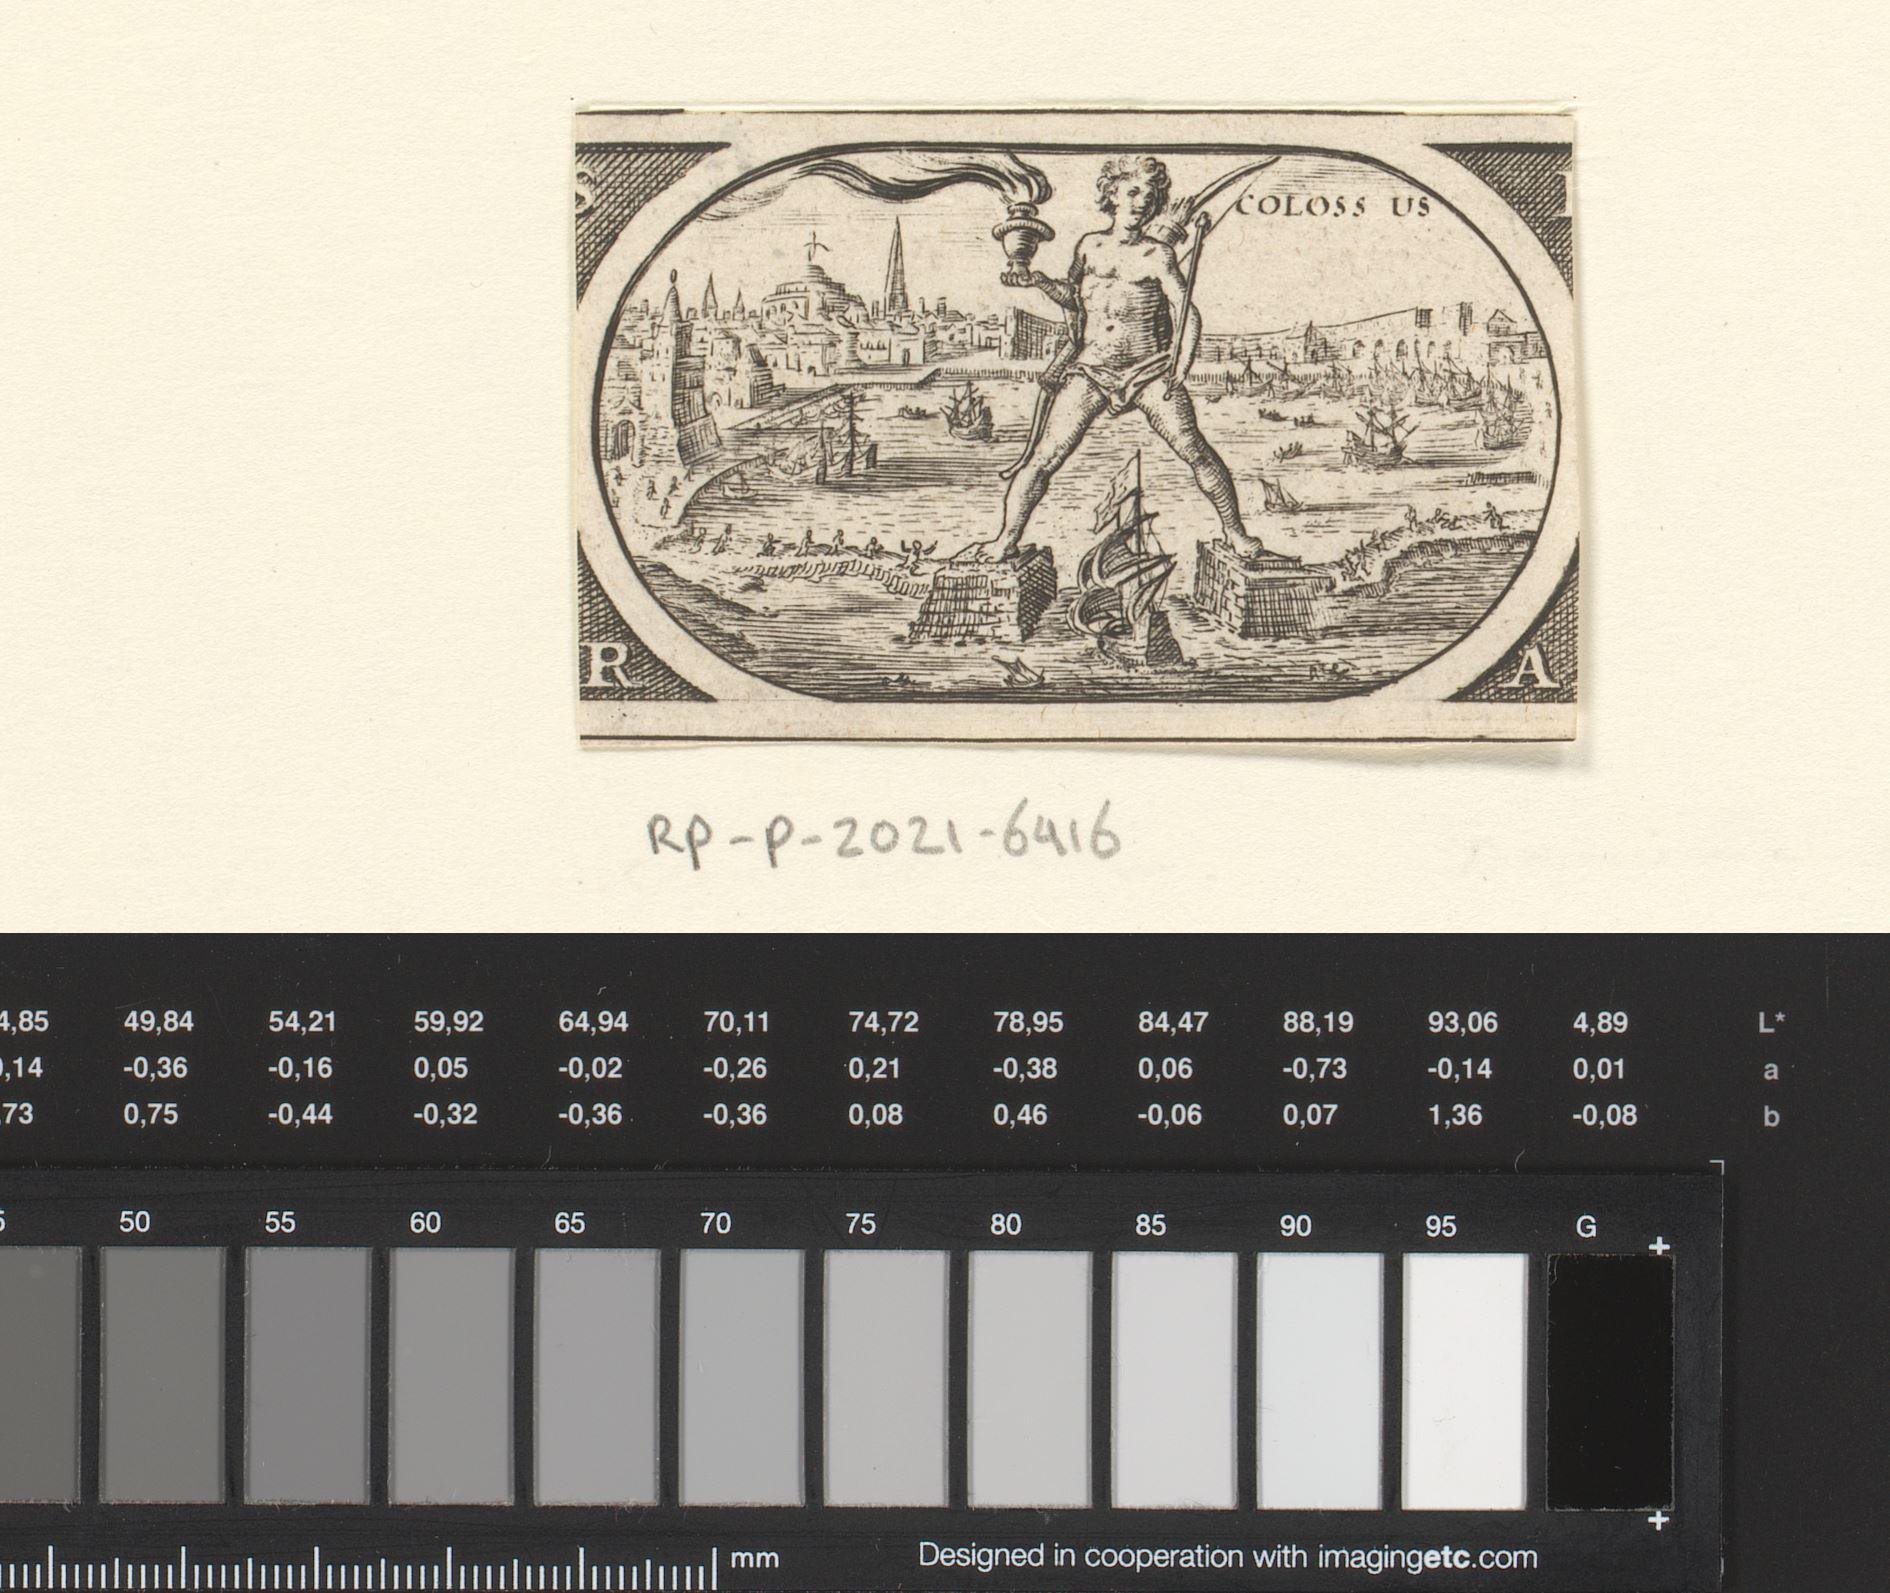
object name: print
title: Kolos van Rhodos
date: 1606-1656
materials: paper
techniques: engraving, etching, letterpress printing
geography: amsterdam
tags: harbour, colossus of rhodes (wonder of the world)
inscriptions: collector's mark: Lugt 2228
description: De prent is afgesneden van de kaart 'Nova totius terrarum orbis geographica ac hydrographica tabula', voor het eerst in 1606 uitgegeven door Willem Janszoon Blaeu. De voorstellingen aan de onderkant van deze kaart zijn gekopieerd naar de serie 'De acht wereldwonderen', door Philips Galle naar Maarten van Heemskerck.